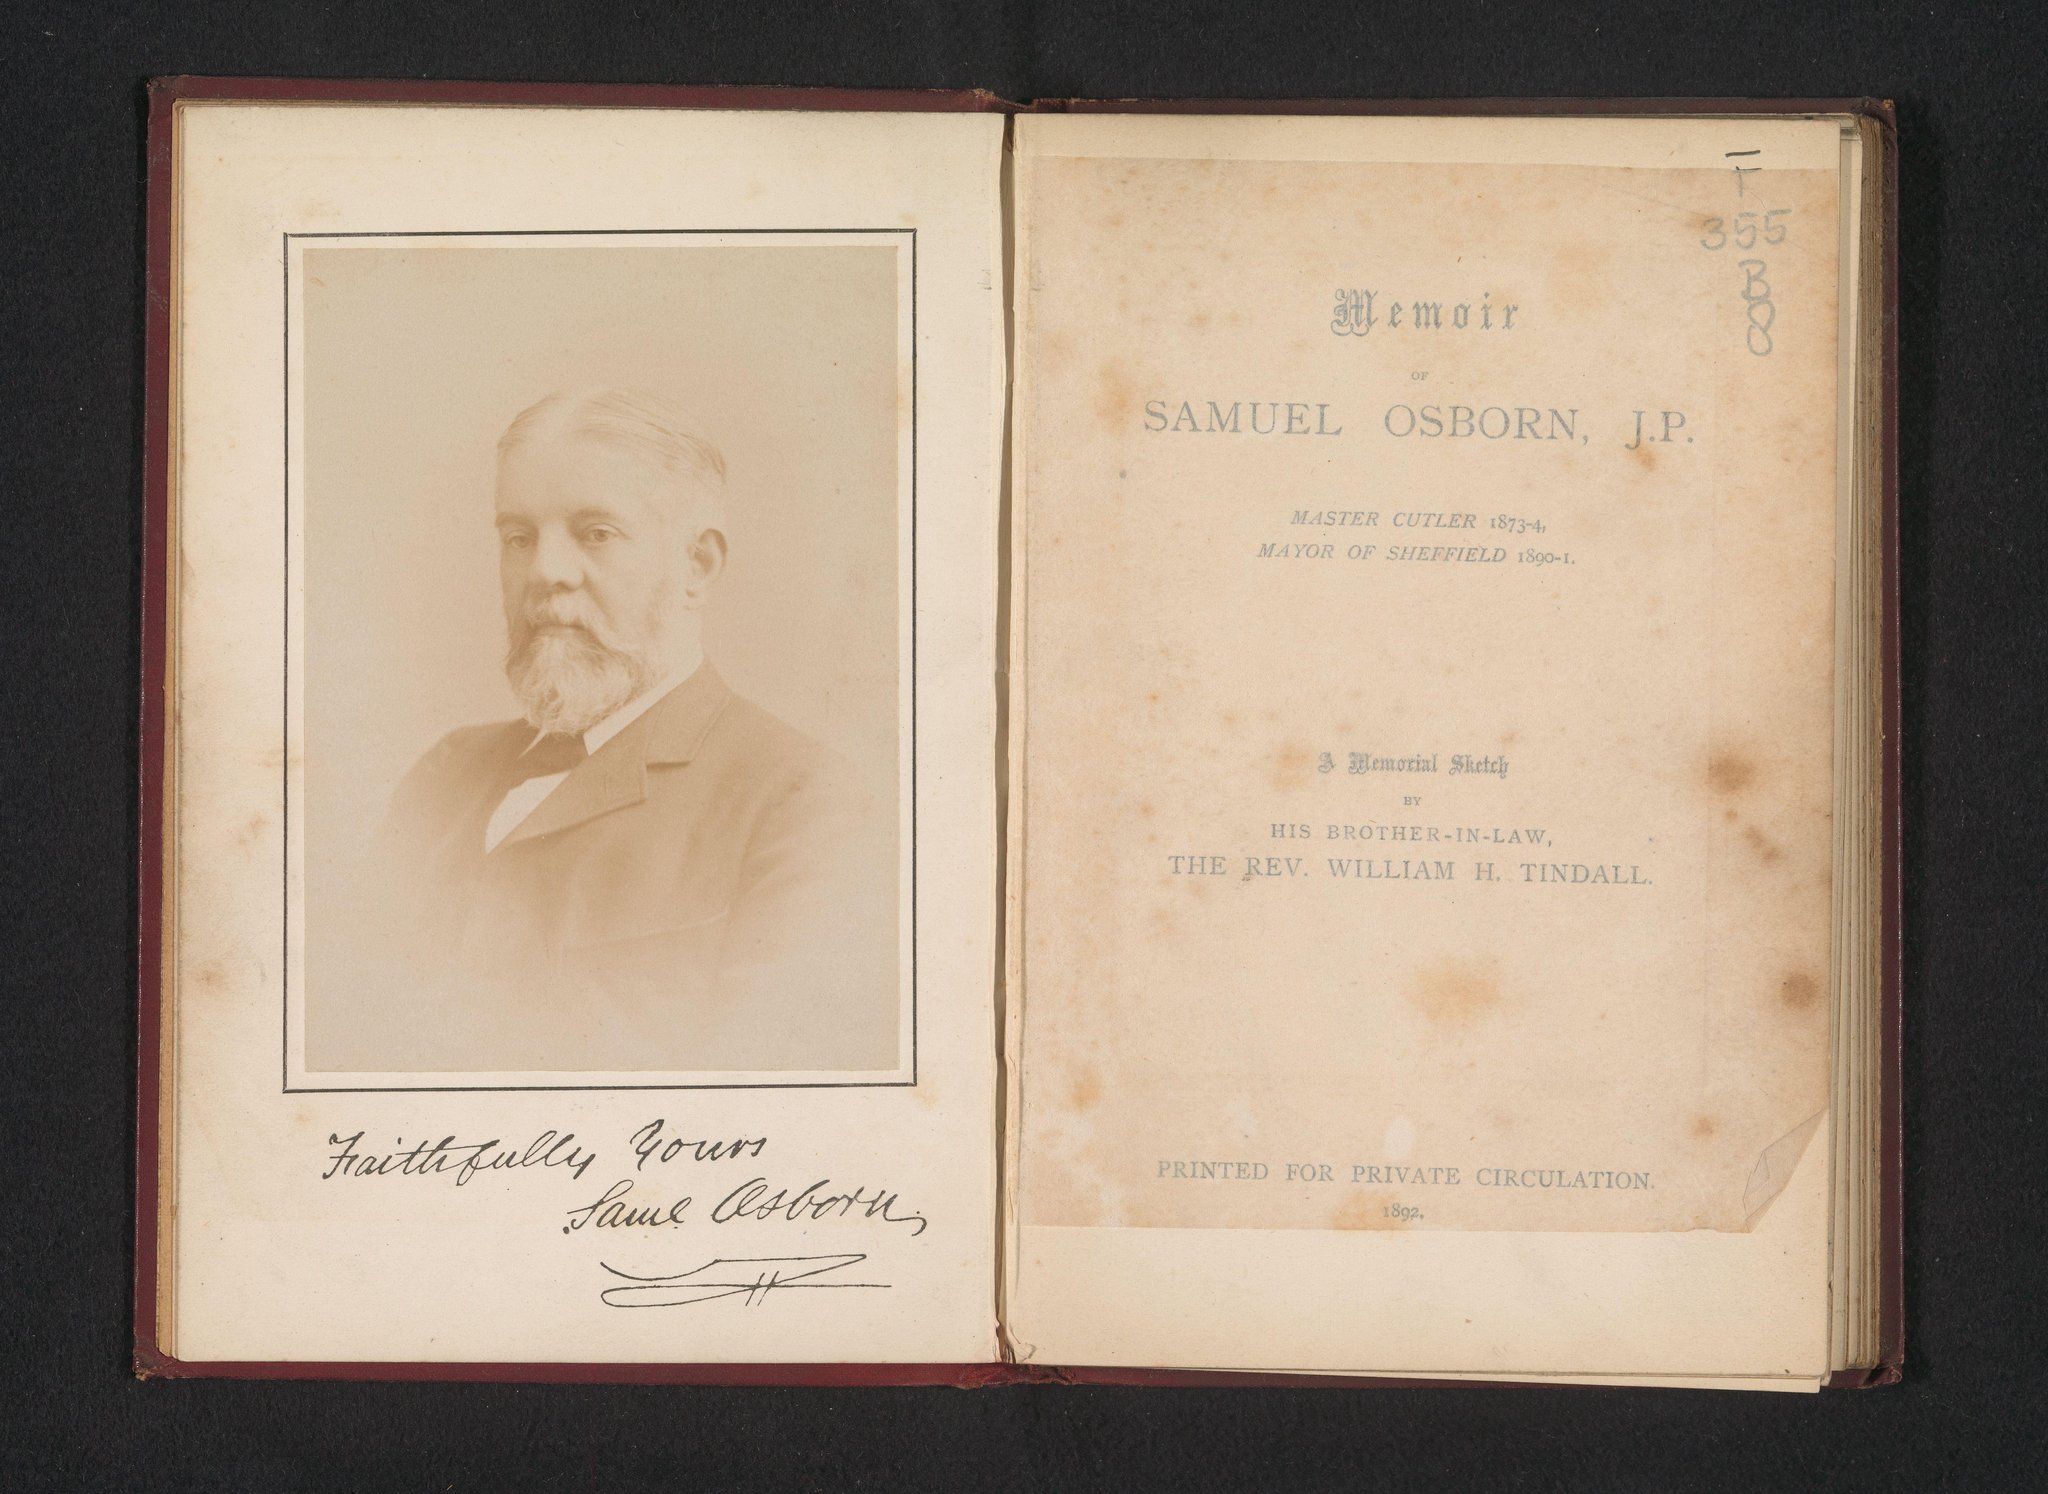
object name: page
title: Faithfully Yours Samuel Osborn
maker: Anonymous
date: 1882-1892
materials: photographic support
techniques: albumen print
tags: mayor, burgomaster, adult man, merchant, salesman